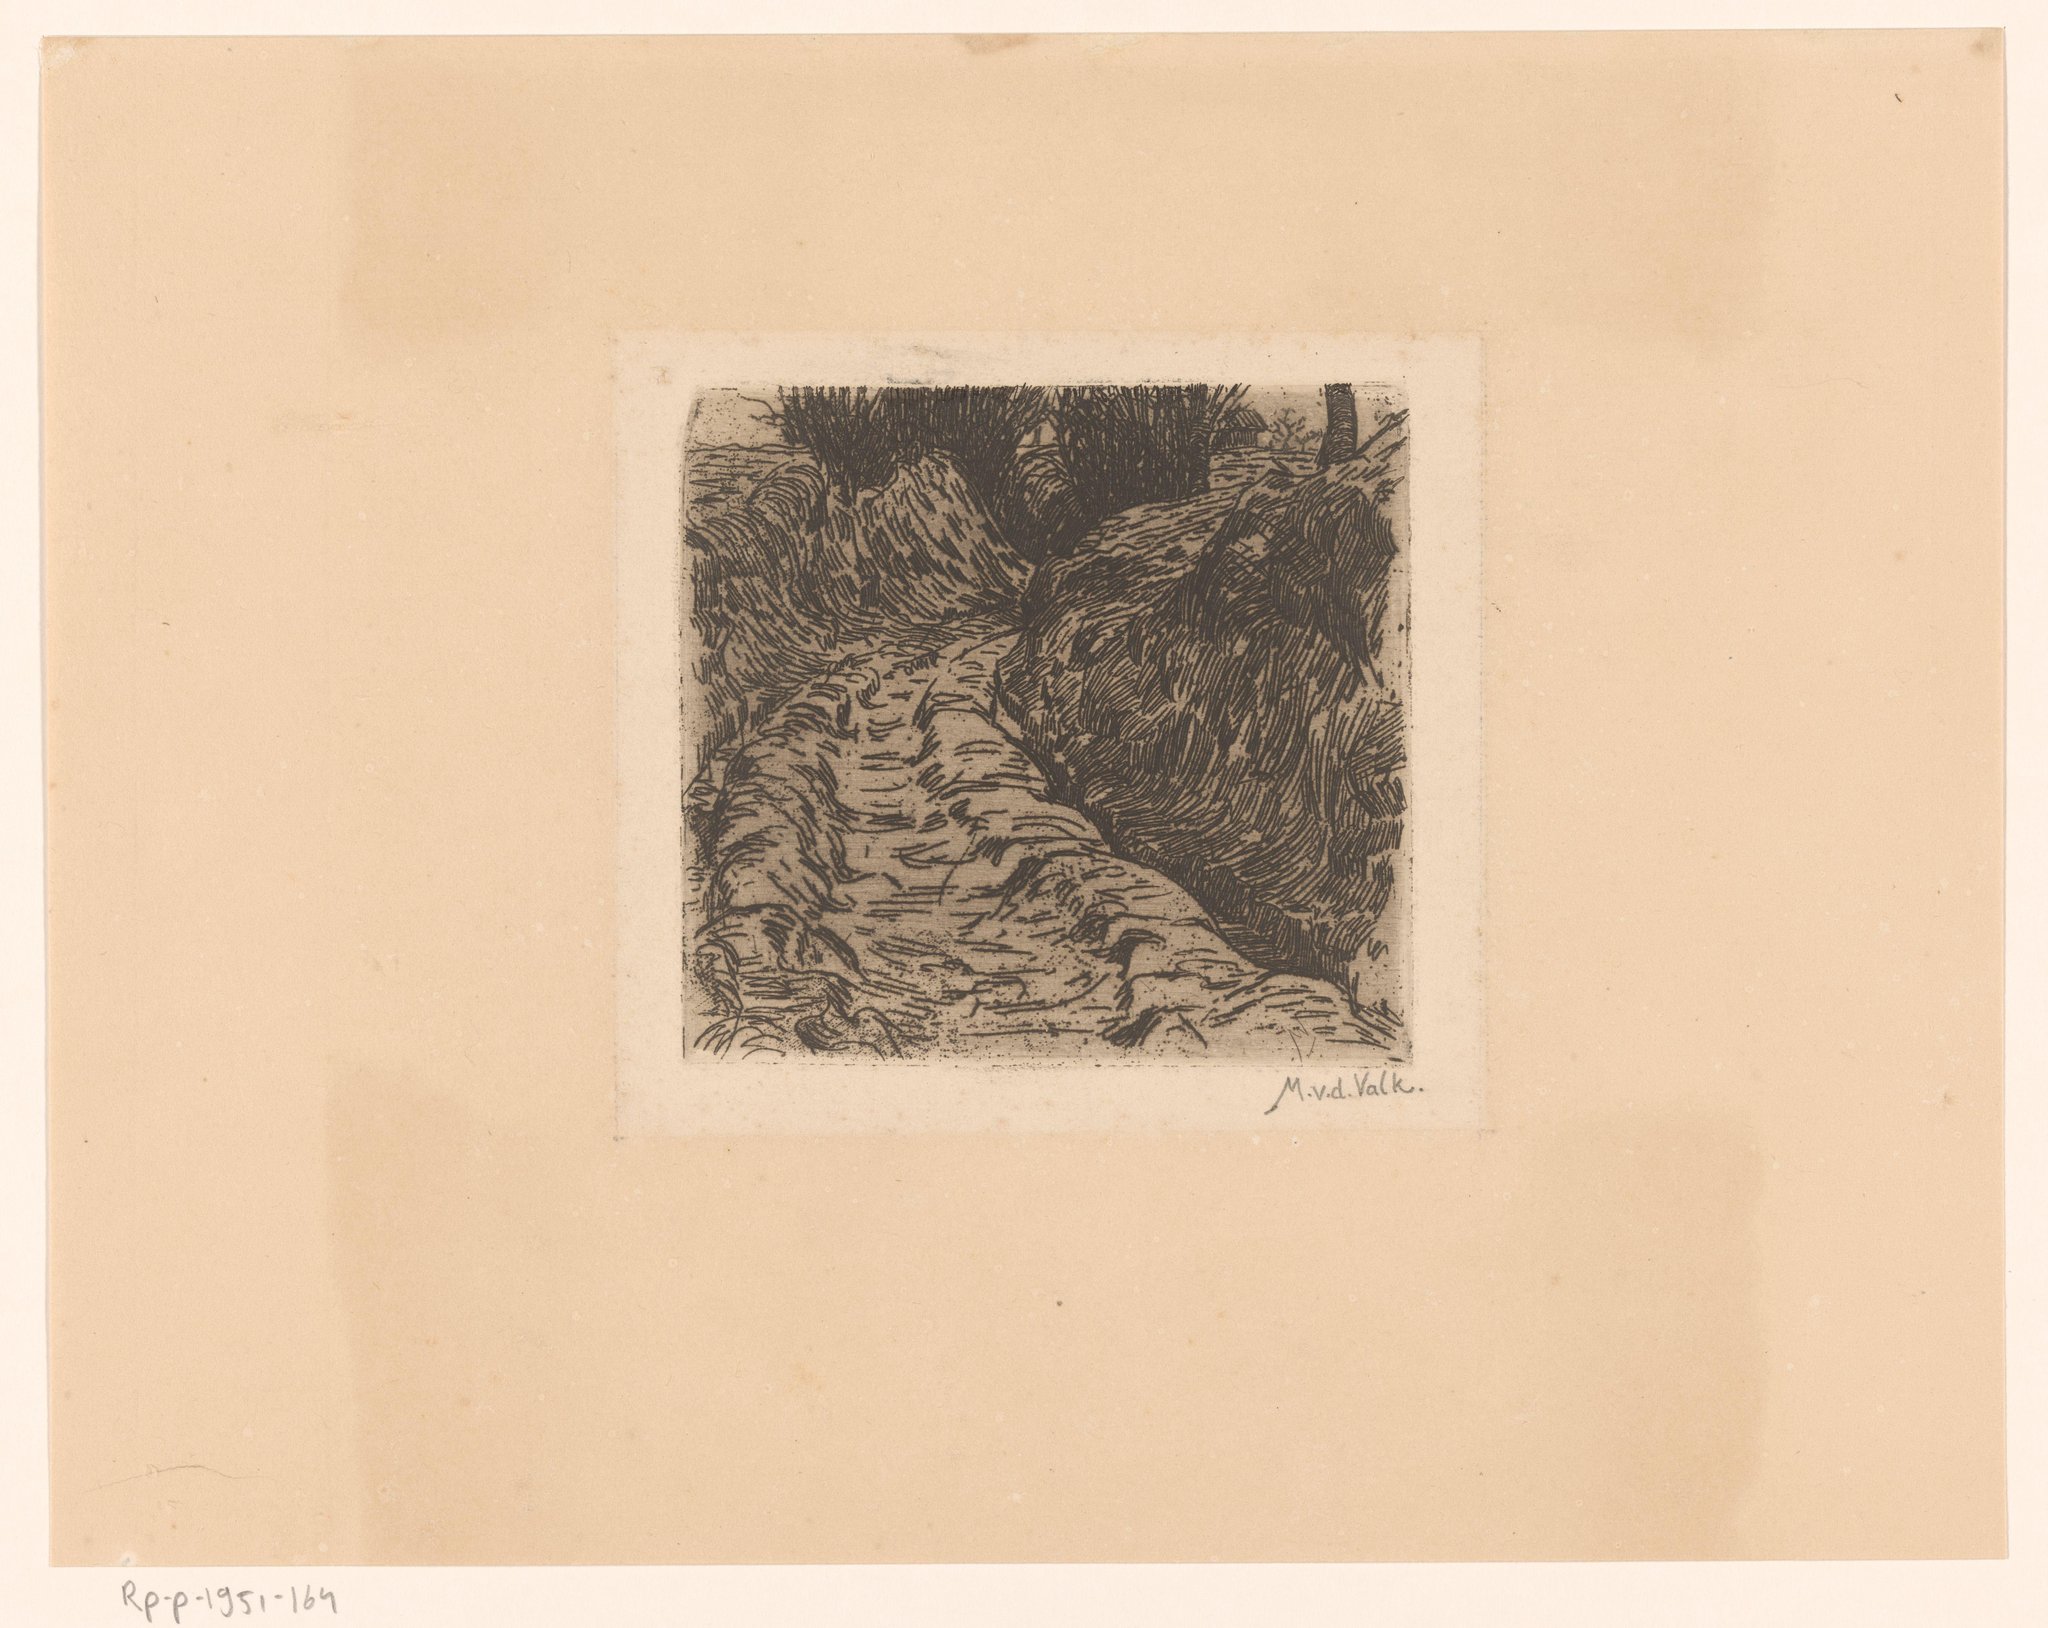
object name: print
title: Landweg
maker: maurits van der valk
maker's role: draughtsman, print maker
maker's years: 1857-1935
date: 1867-1935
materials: paper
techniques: drypoint, etching, intaglio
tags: road, path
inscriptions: collector's mark: Lugt 2228